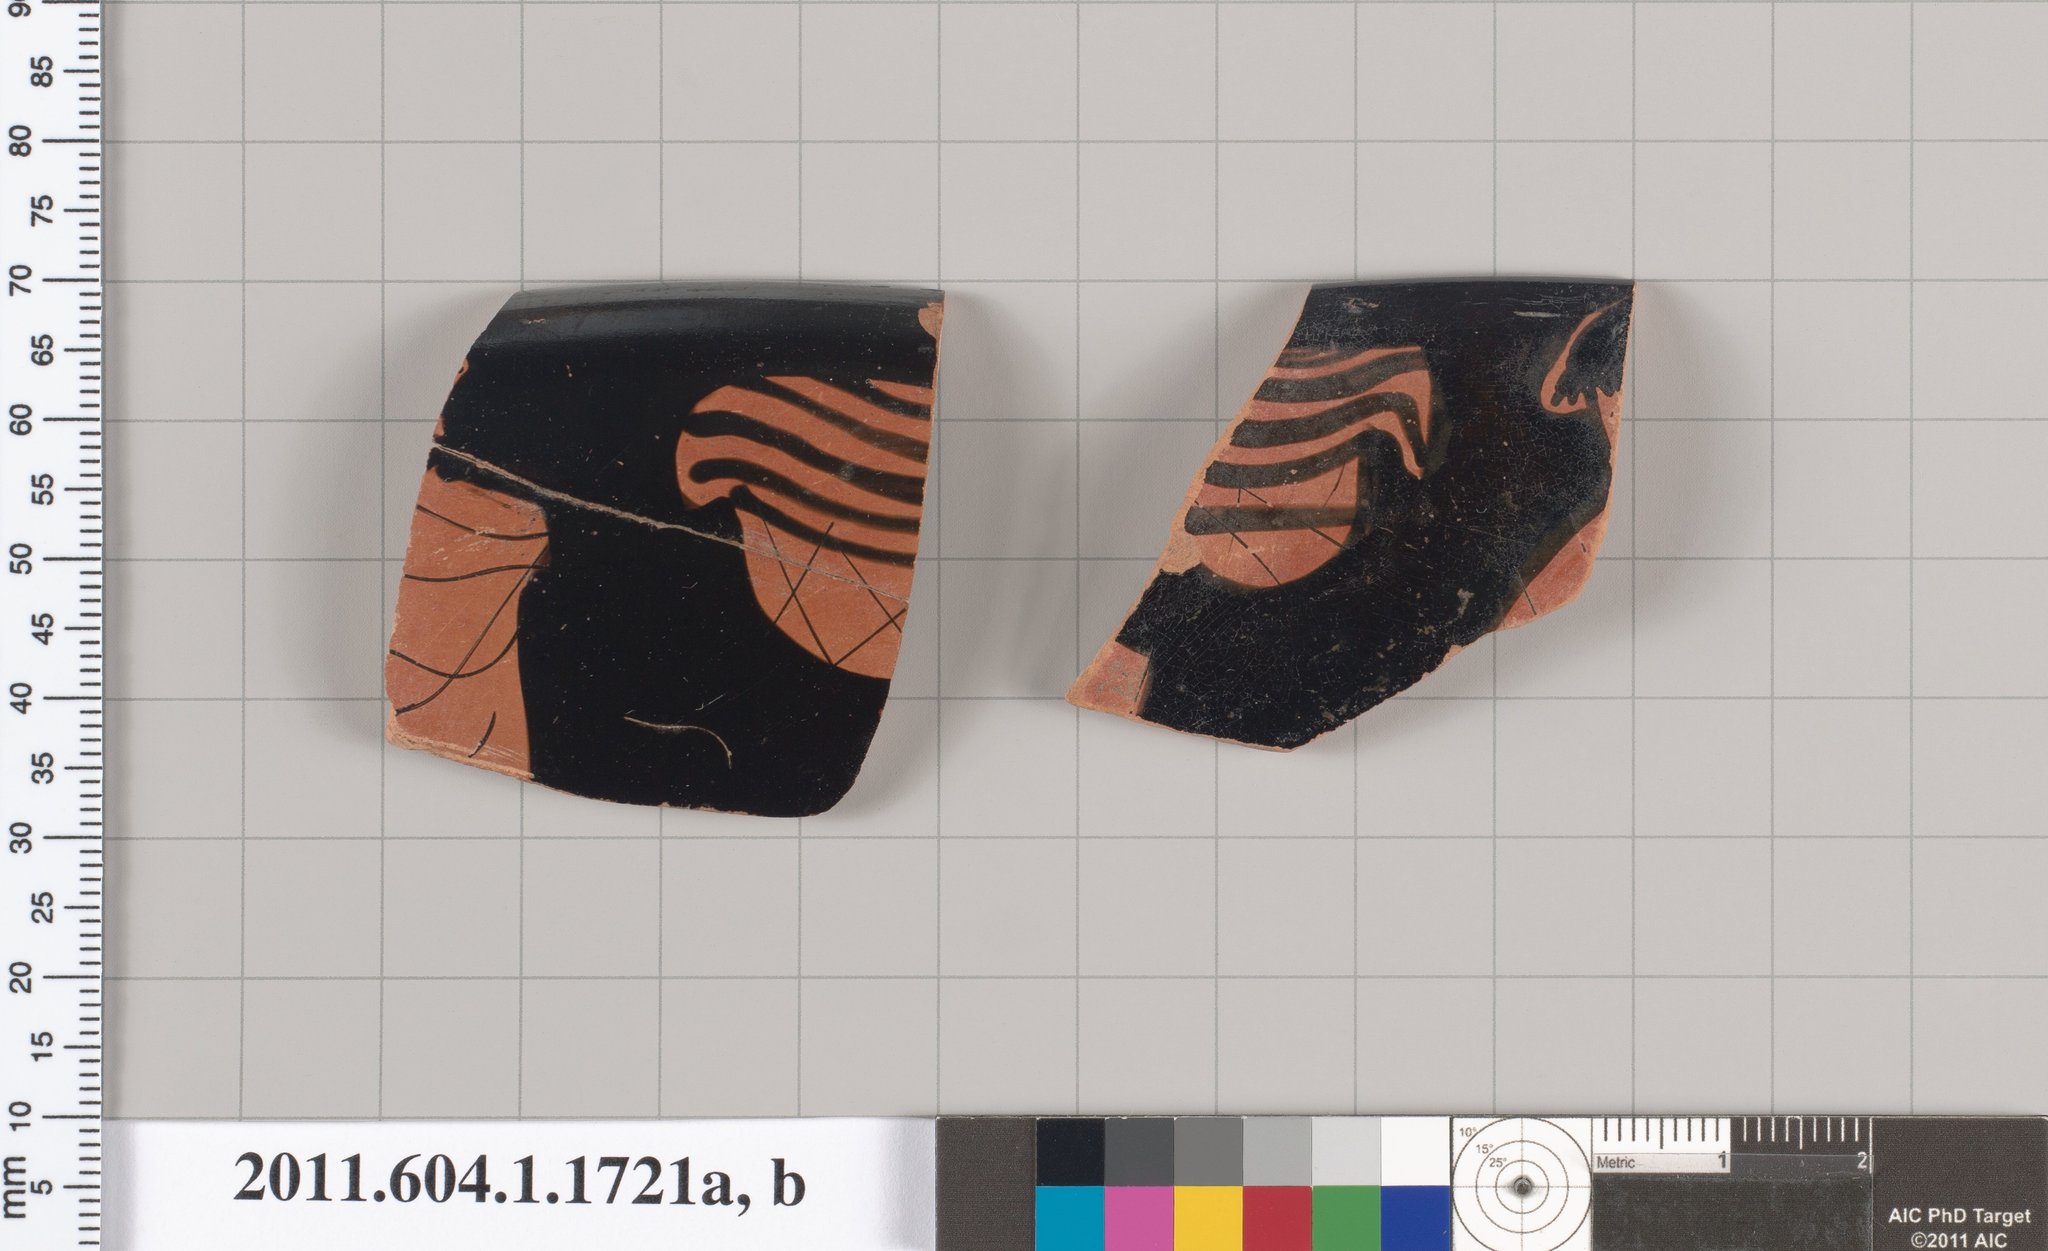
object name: kylix fragment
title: Terracotta rim fragments of a kylix (drinking cup)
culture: greek, attic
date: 475-451 BCE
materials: terracotta